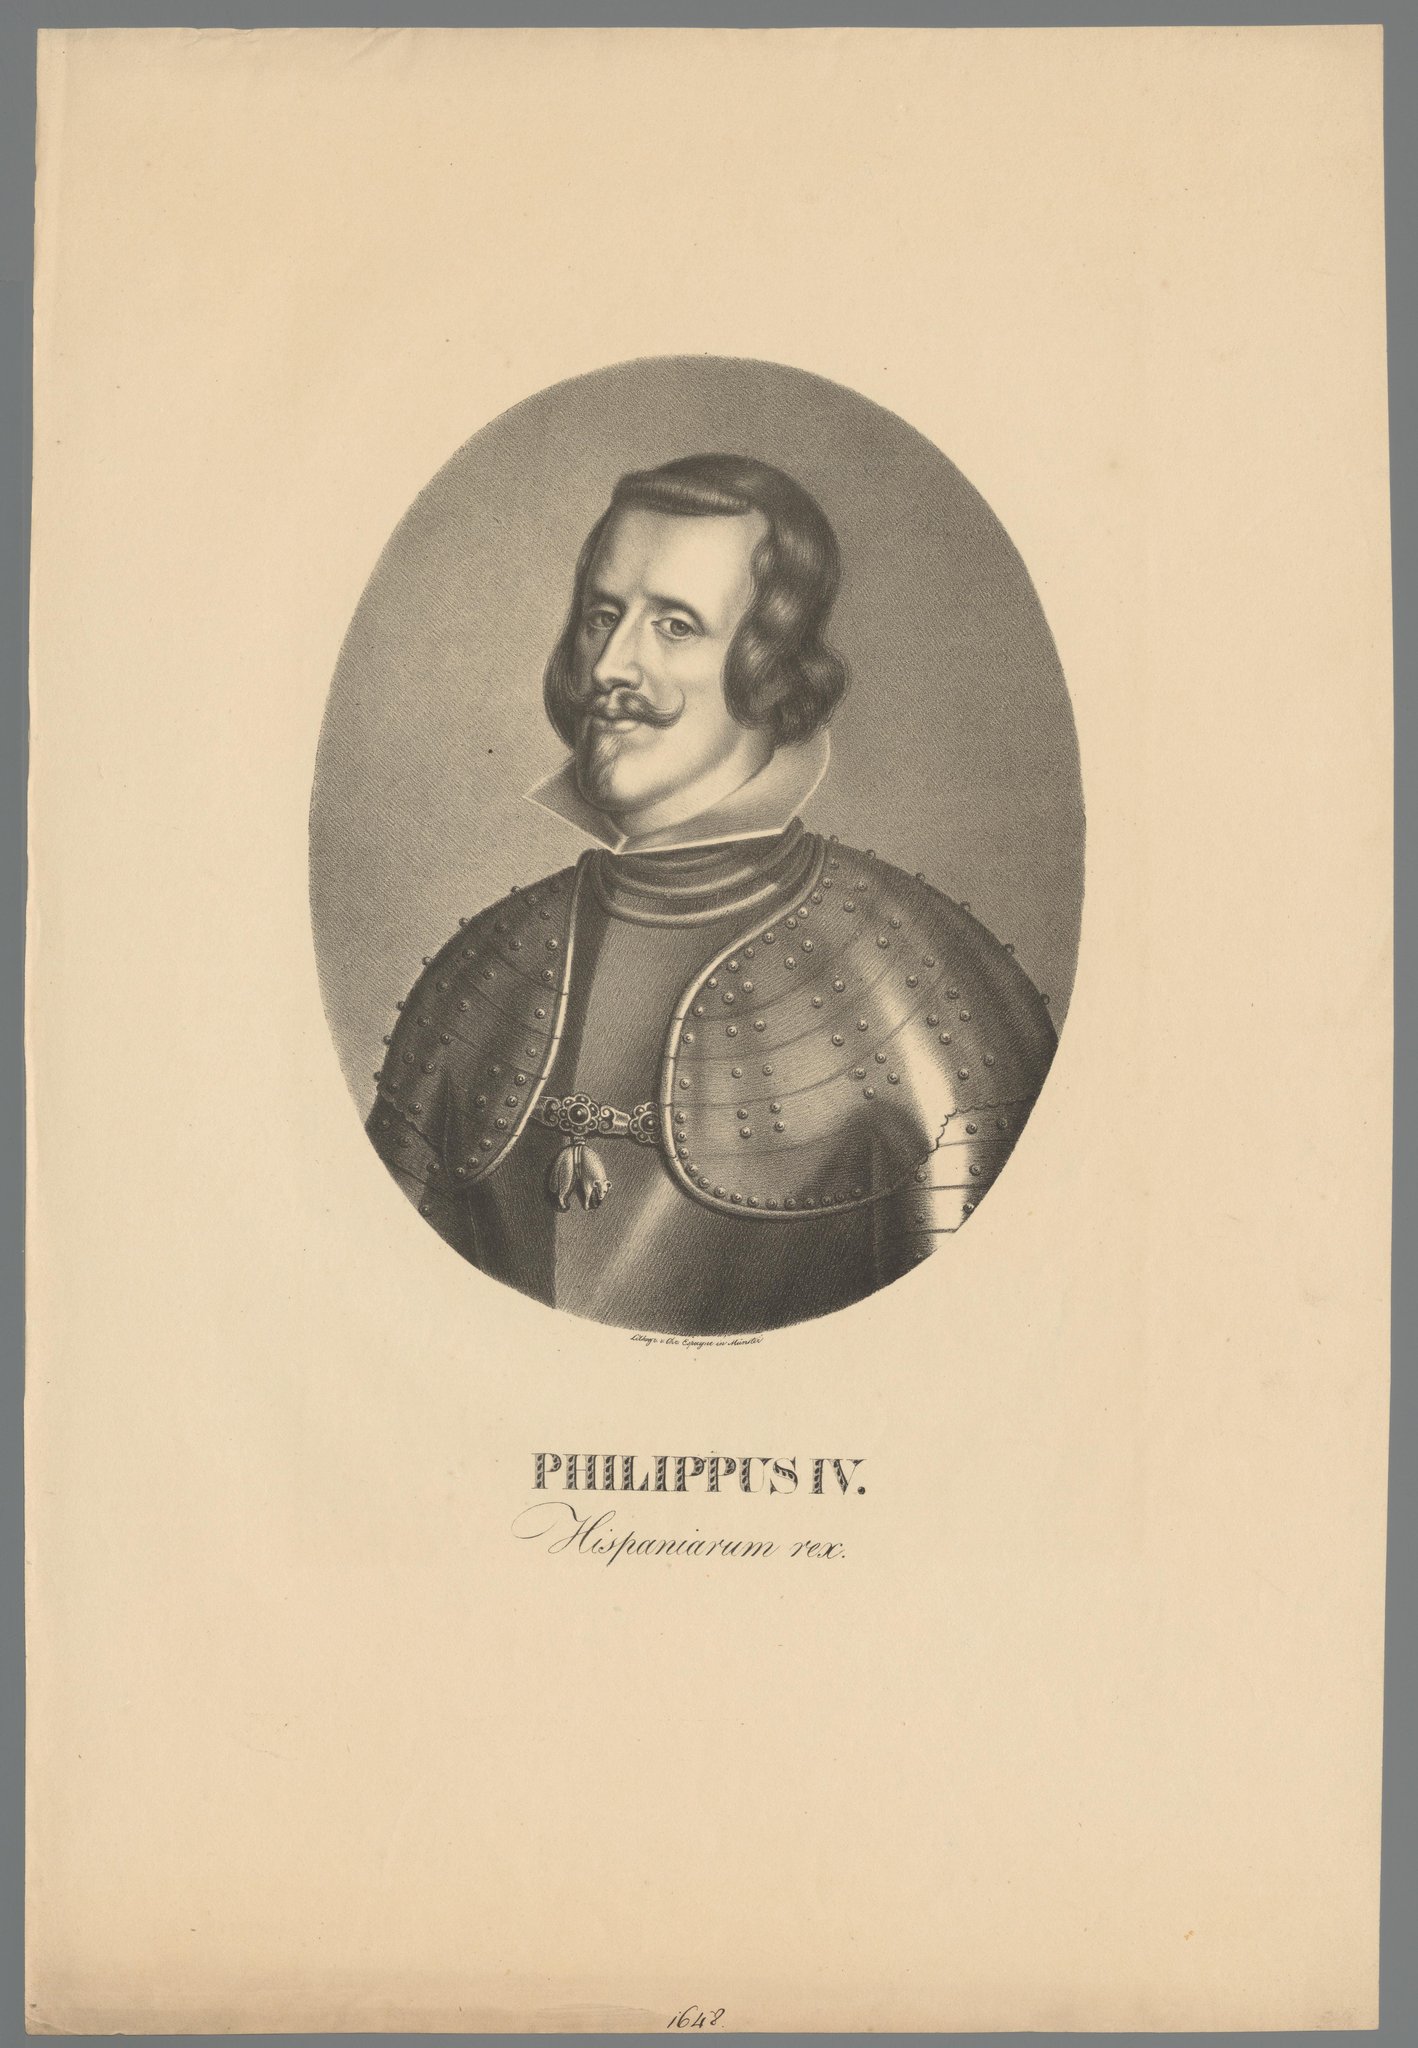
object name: print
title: Portret van Filips IV, koning van Spanje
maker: christian espagne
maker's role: print maker, printer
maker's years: 1794-1838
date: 1824-1827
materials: paper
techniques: lithograph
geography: munster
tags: filips iv (koning van spanje), adult man, historical persons, knighthood order of the golden fleece - insignia of a knighthood order, e.g.: badge, chain (with name of order), beard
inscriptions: collector's mark: Lugt 2228, inscription: ‘1648’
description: Prent uit: Bildnisse der beim westfälischen Friedensschluß zu Münster und Osnabrück versammelt gewesenen Gesandten. Münster: Christian Espagne, [1824-1827]. Deze publicatie bevat een onbekend aantal lithografieën, die in afleveringen verschenen als illustratie bij de tekst.